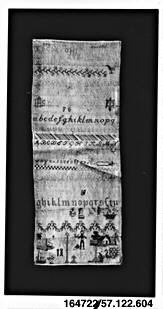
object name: sampler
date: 1828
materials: canvas, silk, wool